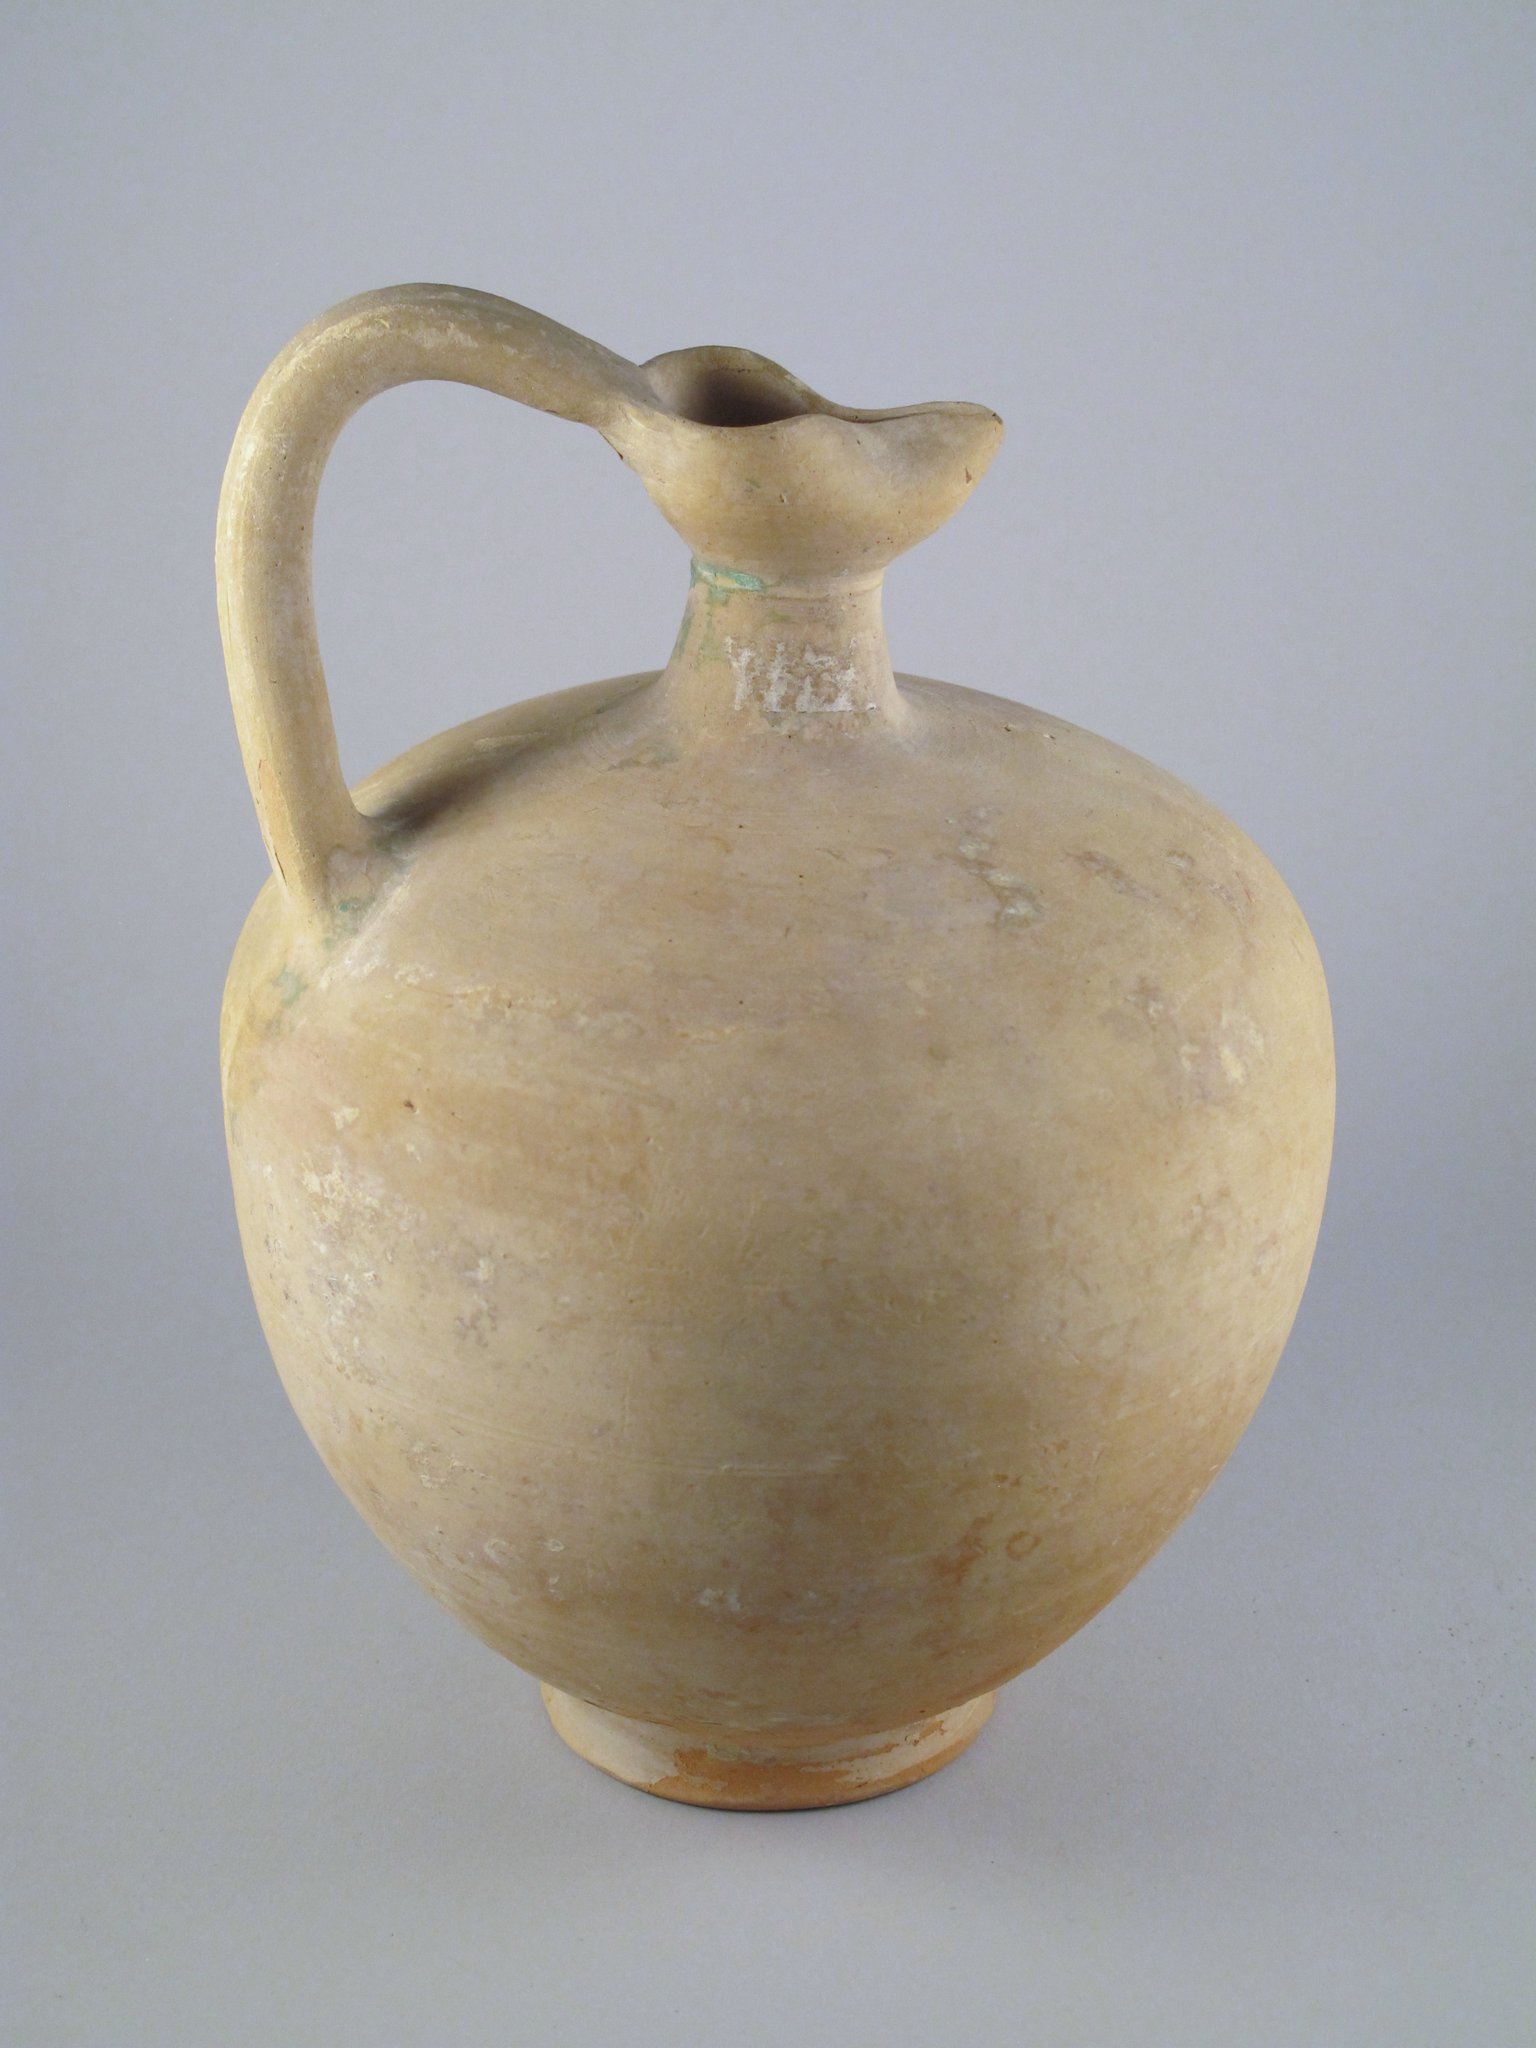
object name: jug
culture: cypriot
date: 480-400 BCE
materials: terracotta